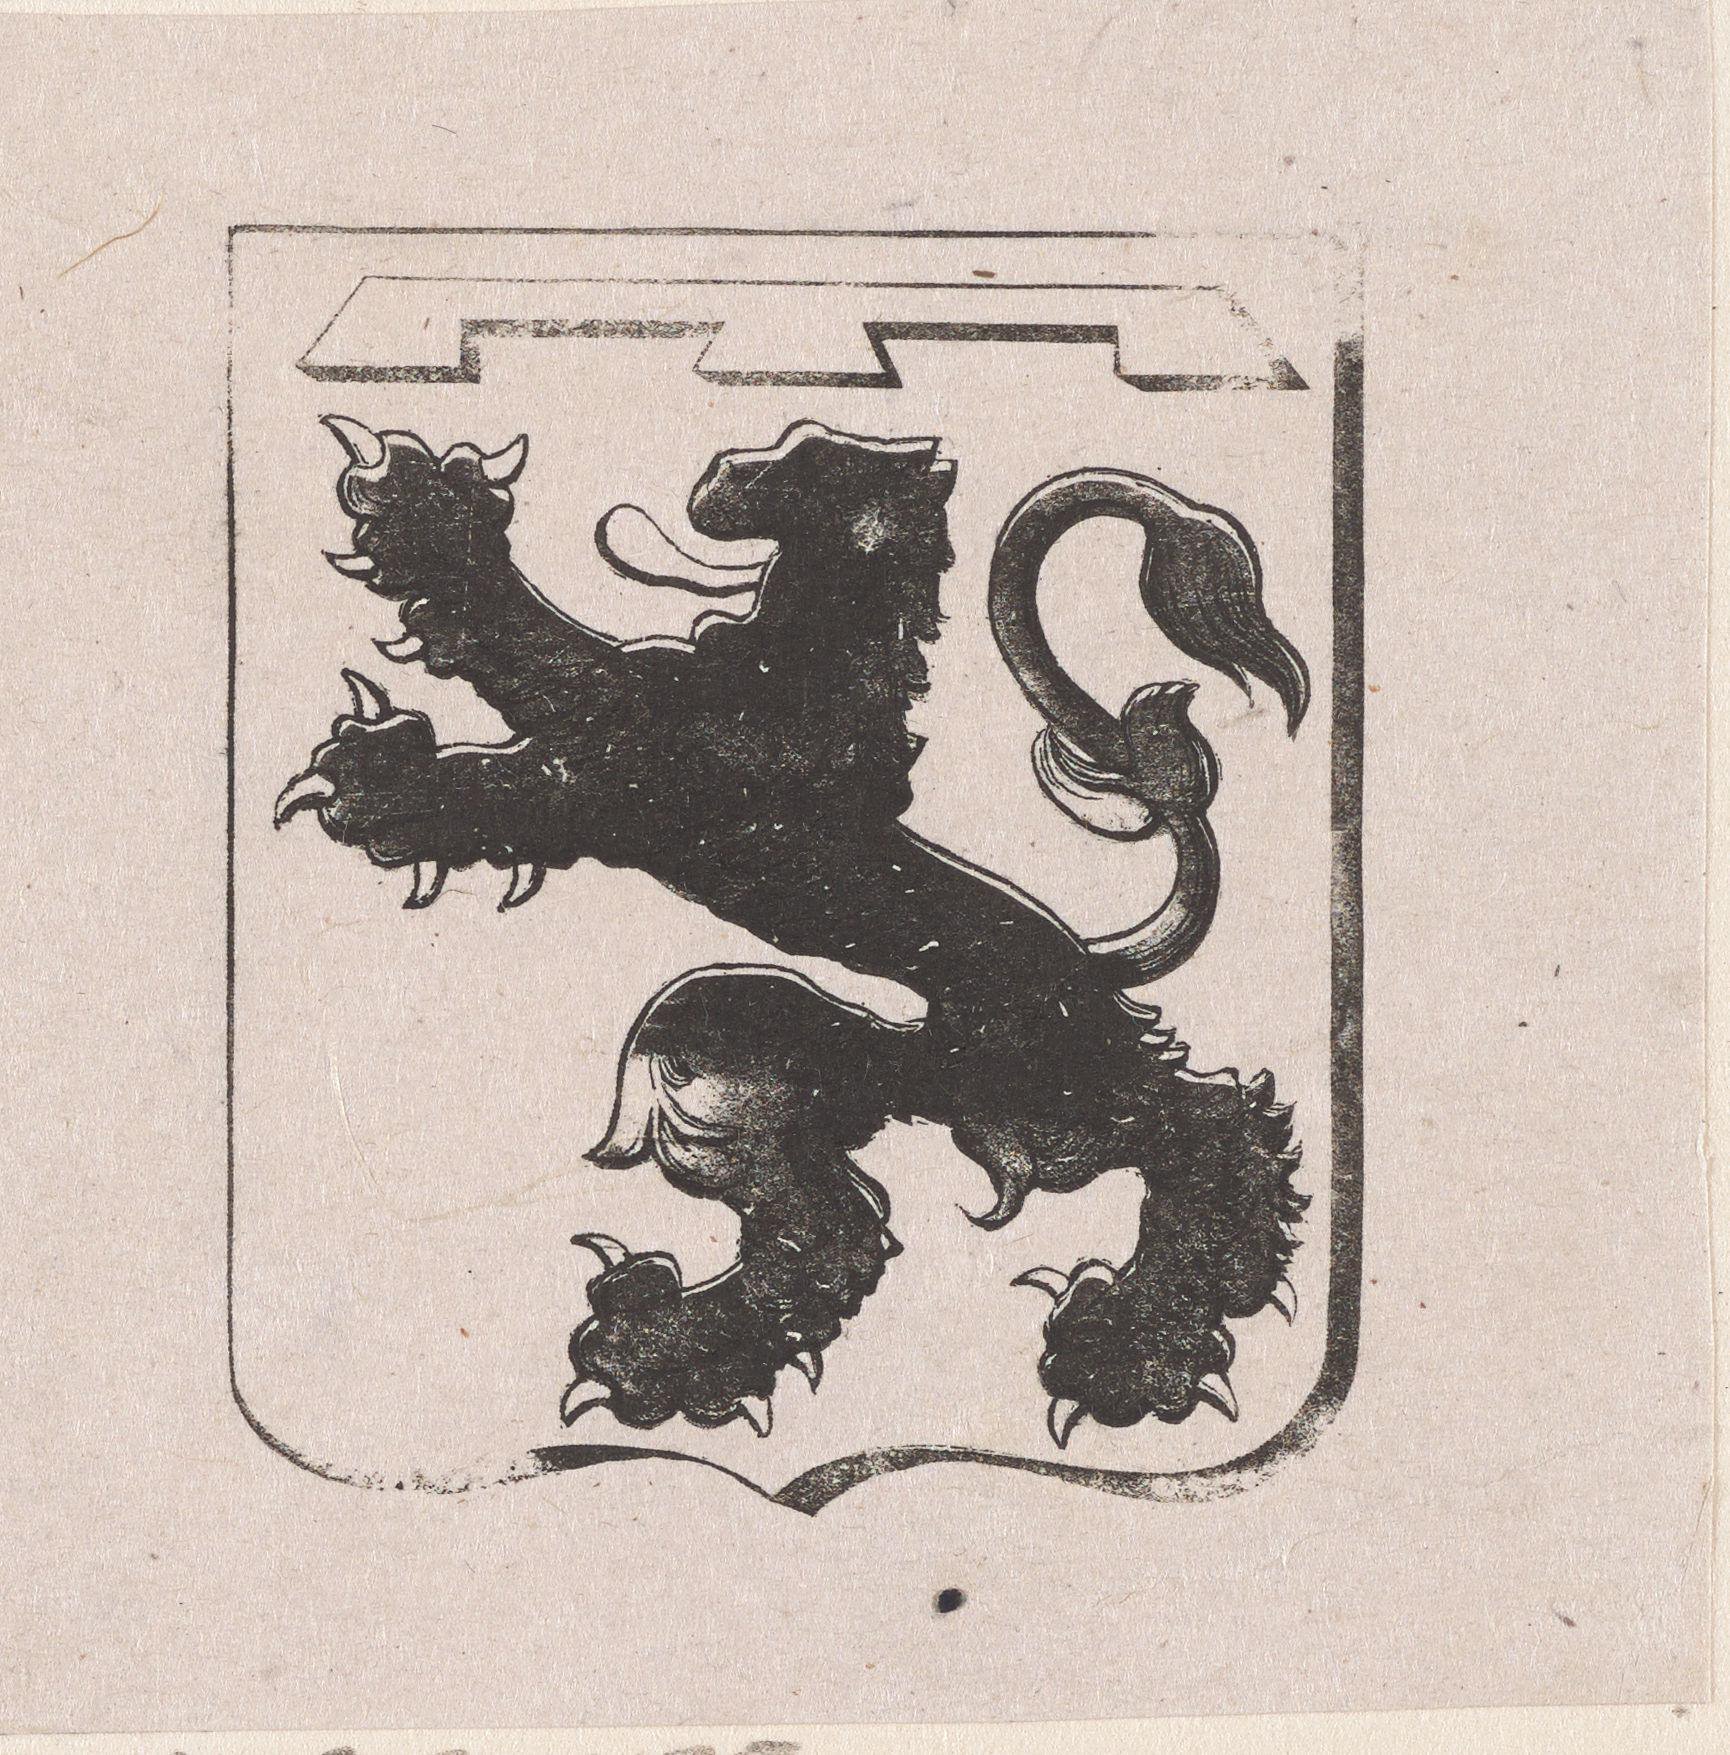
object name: print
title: Vignet met een wapen met daarop het silhouet van een leeuw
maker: isaac weissenbruch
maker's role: print maker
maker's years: 1826-1912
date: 1836-1912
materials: paper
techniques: engraving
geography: netherlands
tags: coat of arms (as symbol of the state, etc.), beasts of prey, predatory animals: lion, vignette